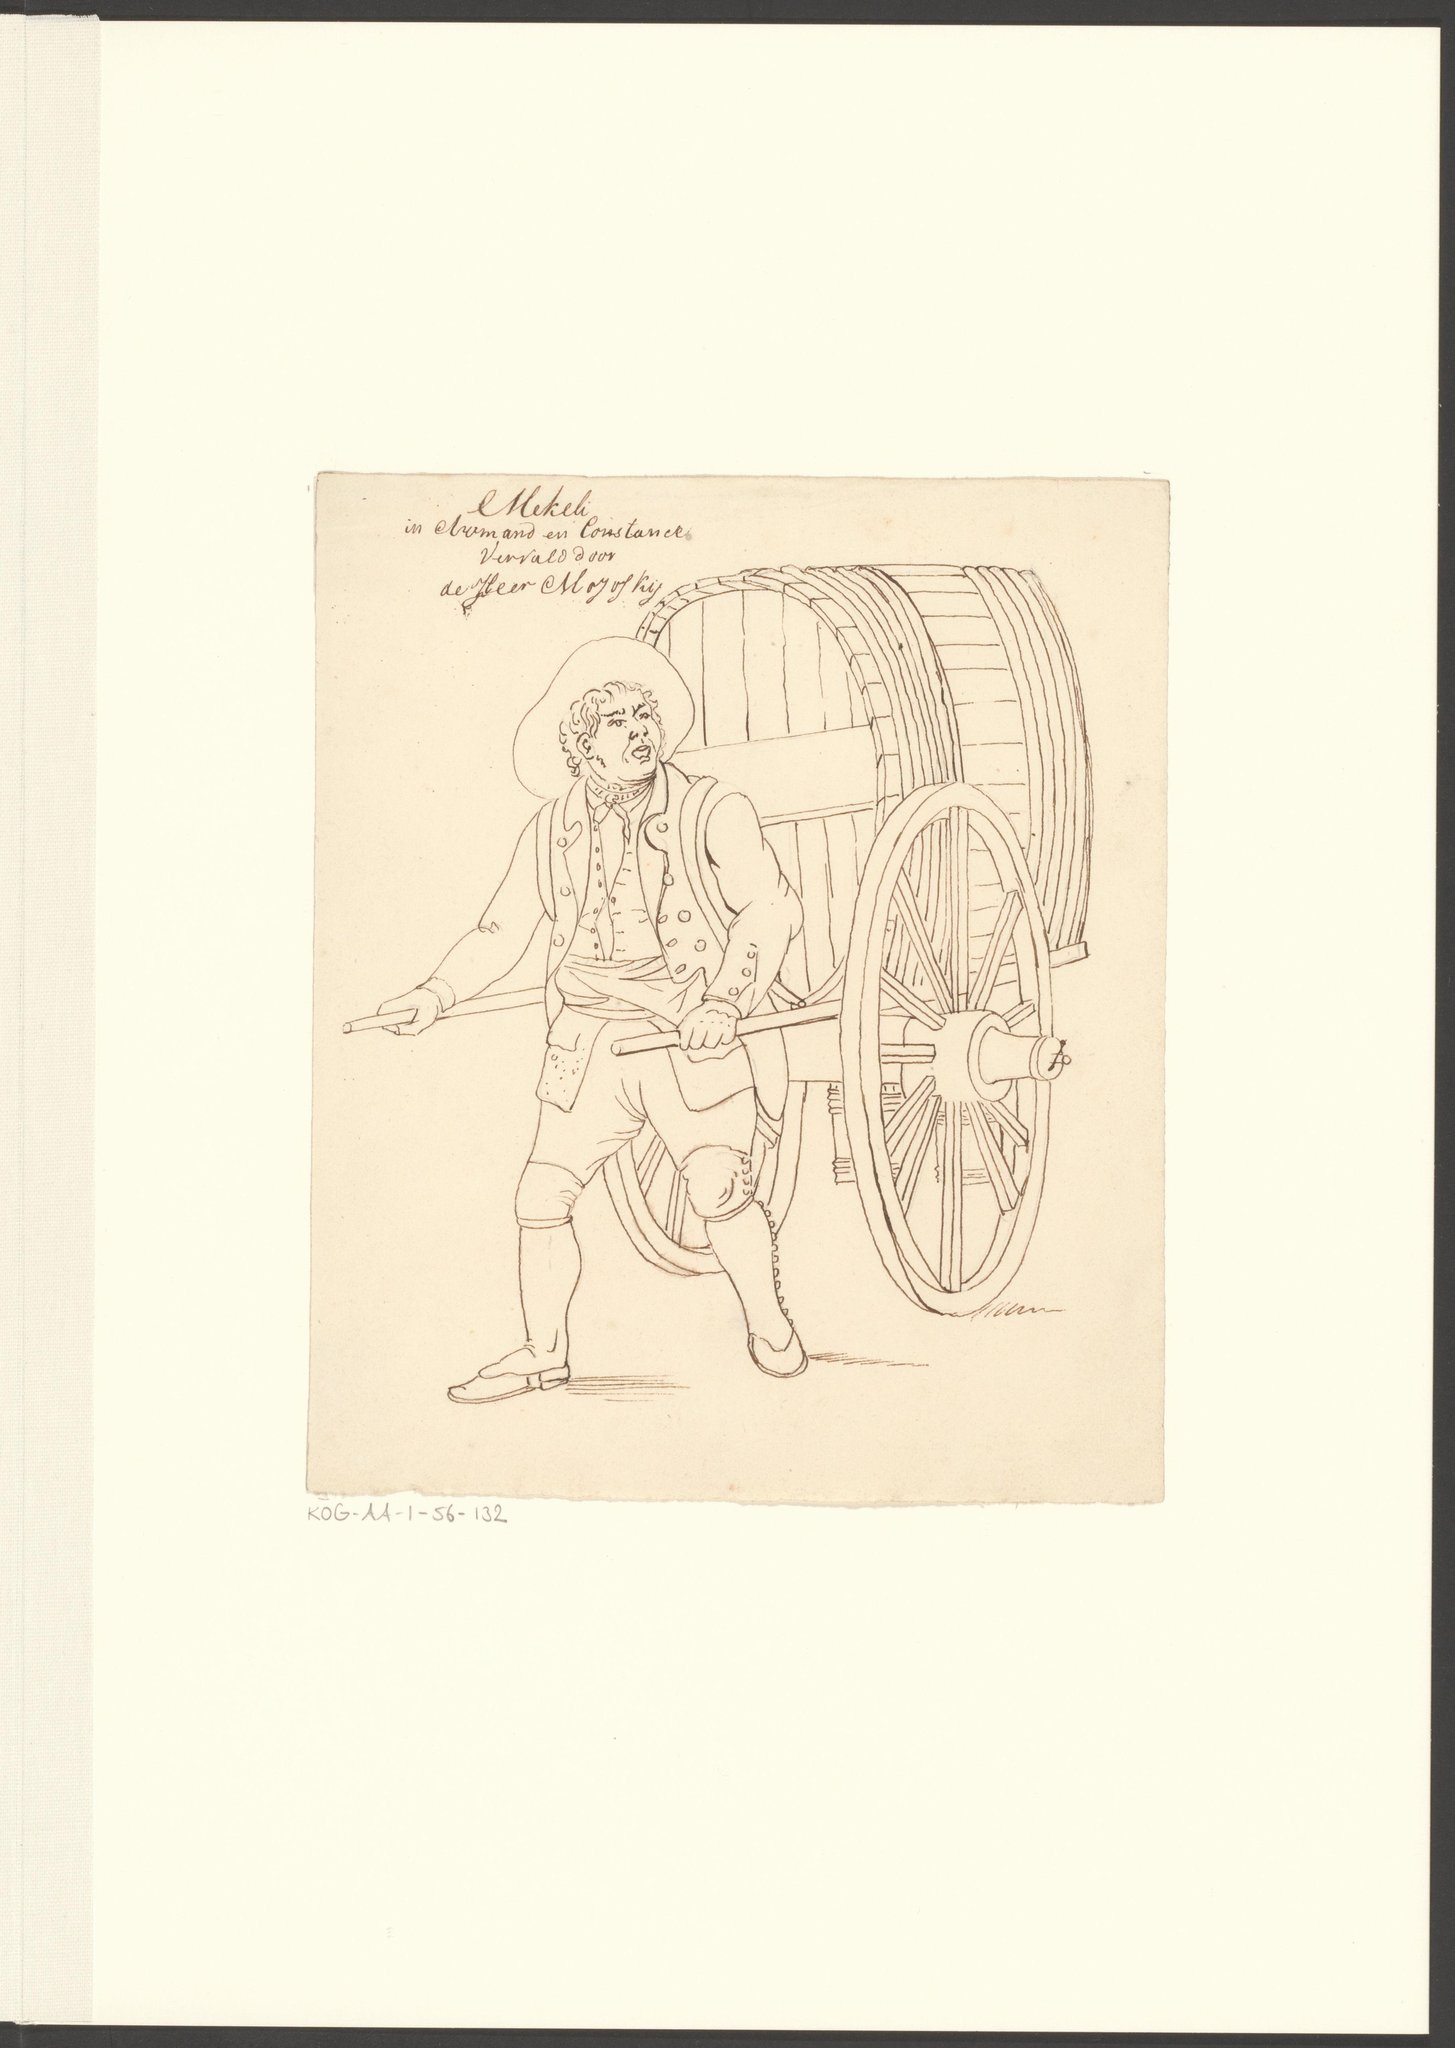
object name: drawing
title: Portret van toneelspeler Theo Majofski in de rol van Mekéli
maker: johannes jelgerhuis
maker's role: draughtsman, painter, print maker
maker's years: 1770-1836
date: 1791-1836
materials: ink, paper, pencil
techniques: pen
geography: amsterdam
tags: historical persons, portrait of actor, actress, actor (on the stage), amsterdam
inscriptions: inscription: ‘Mekeli / in Armand en Constance / vervuld door / de Heer Majoskij’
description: Voorbereidende tekening op de prentserie Acteurs en actrices in verschillende rollen van Johannes Jelgerhuis.